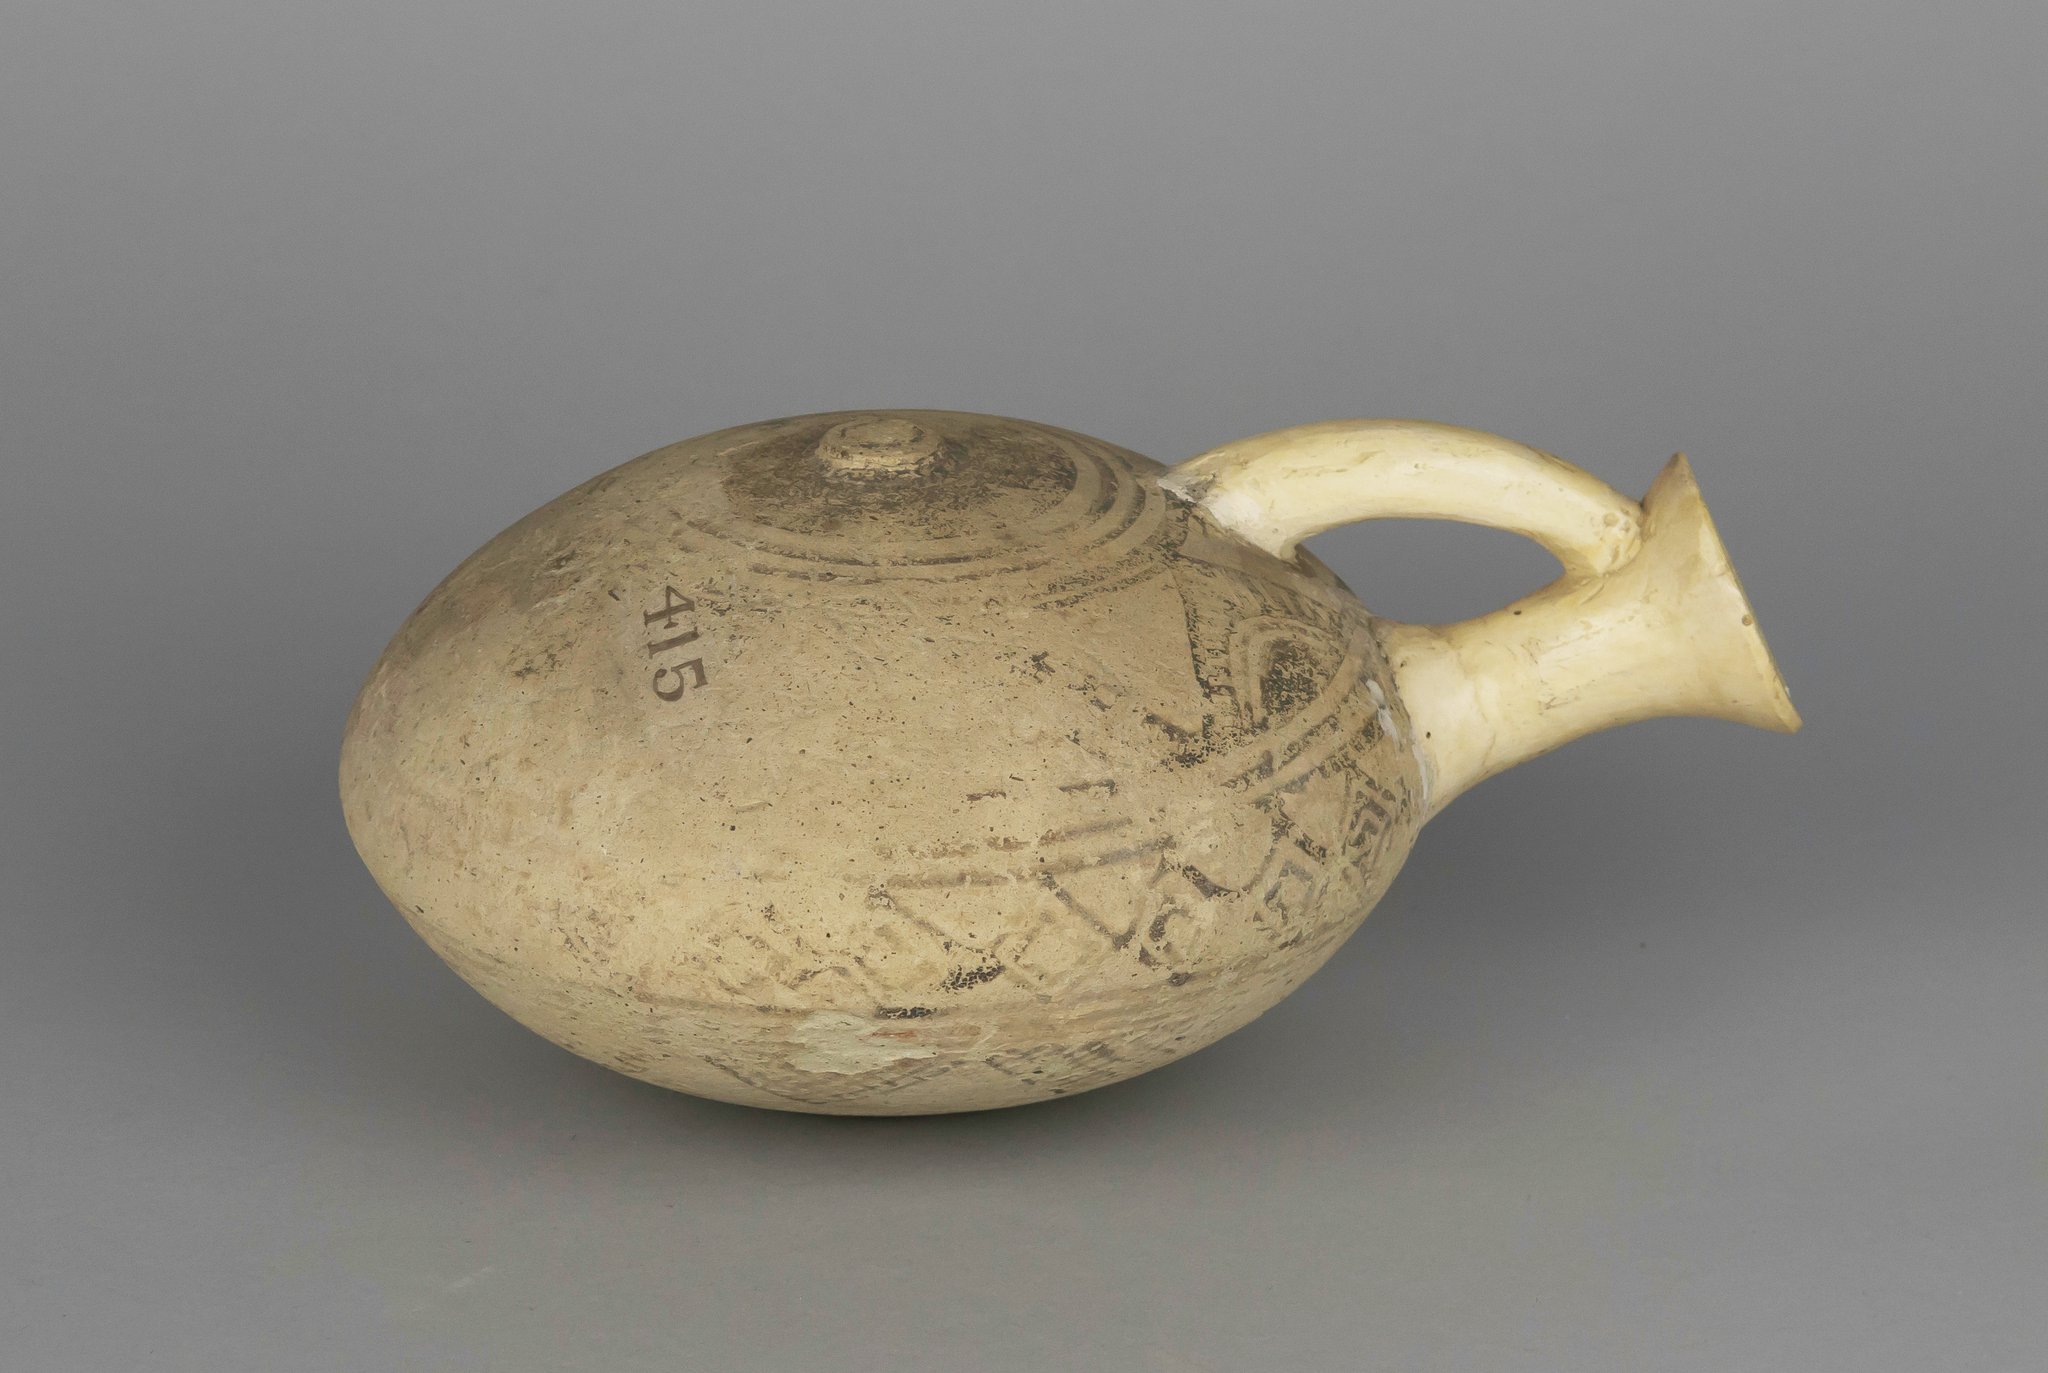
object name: flask, lentoid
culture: cypriot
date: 1200-1050 BCE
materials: terracotta